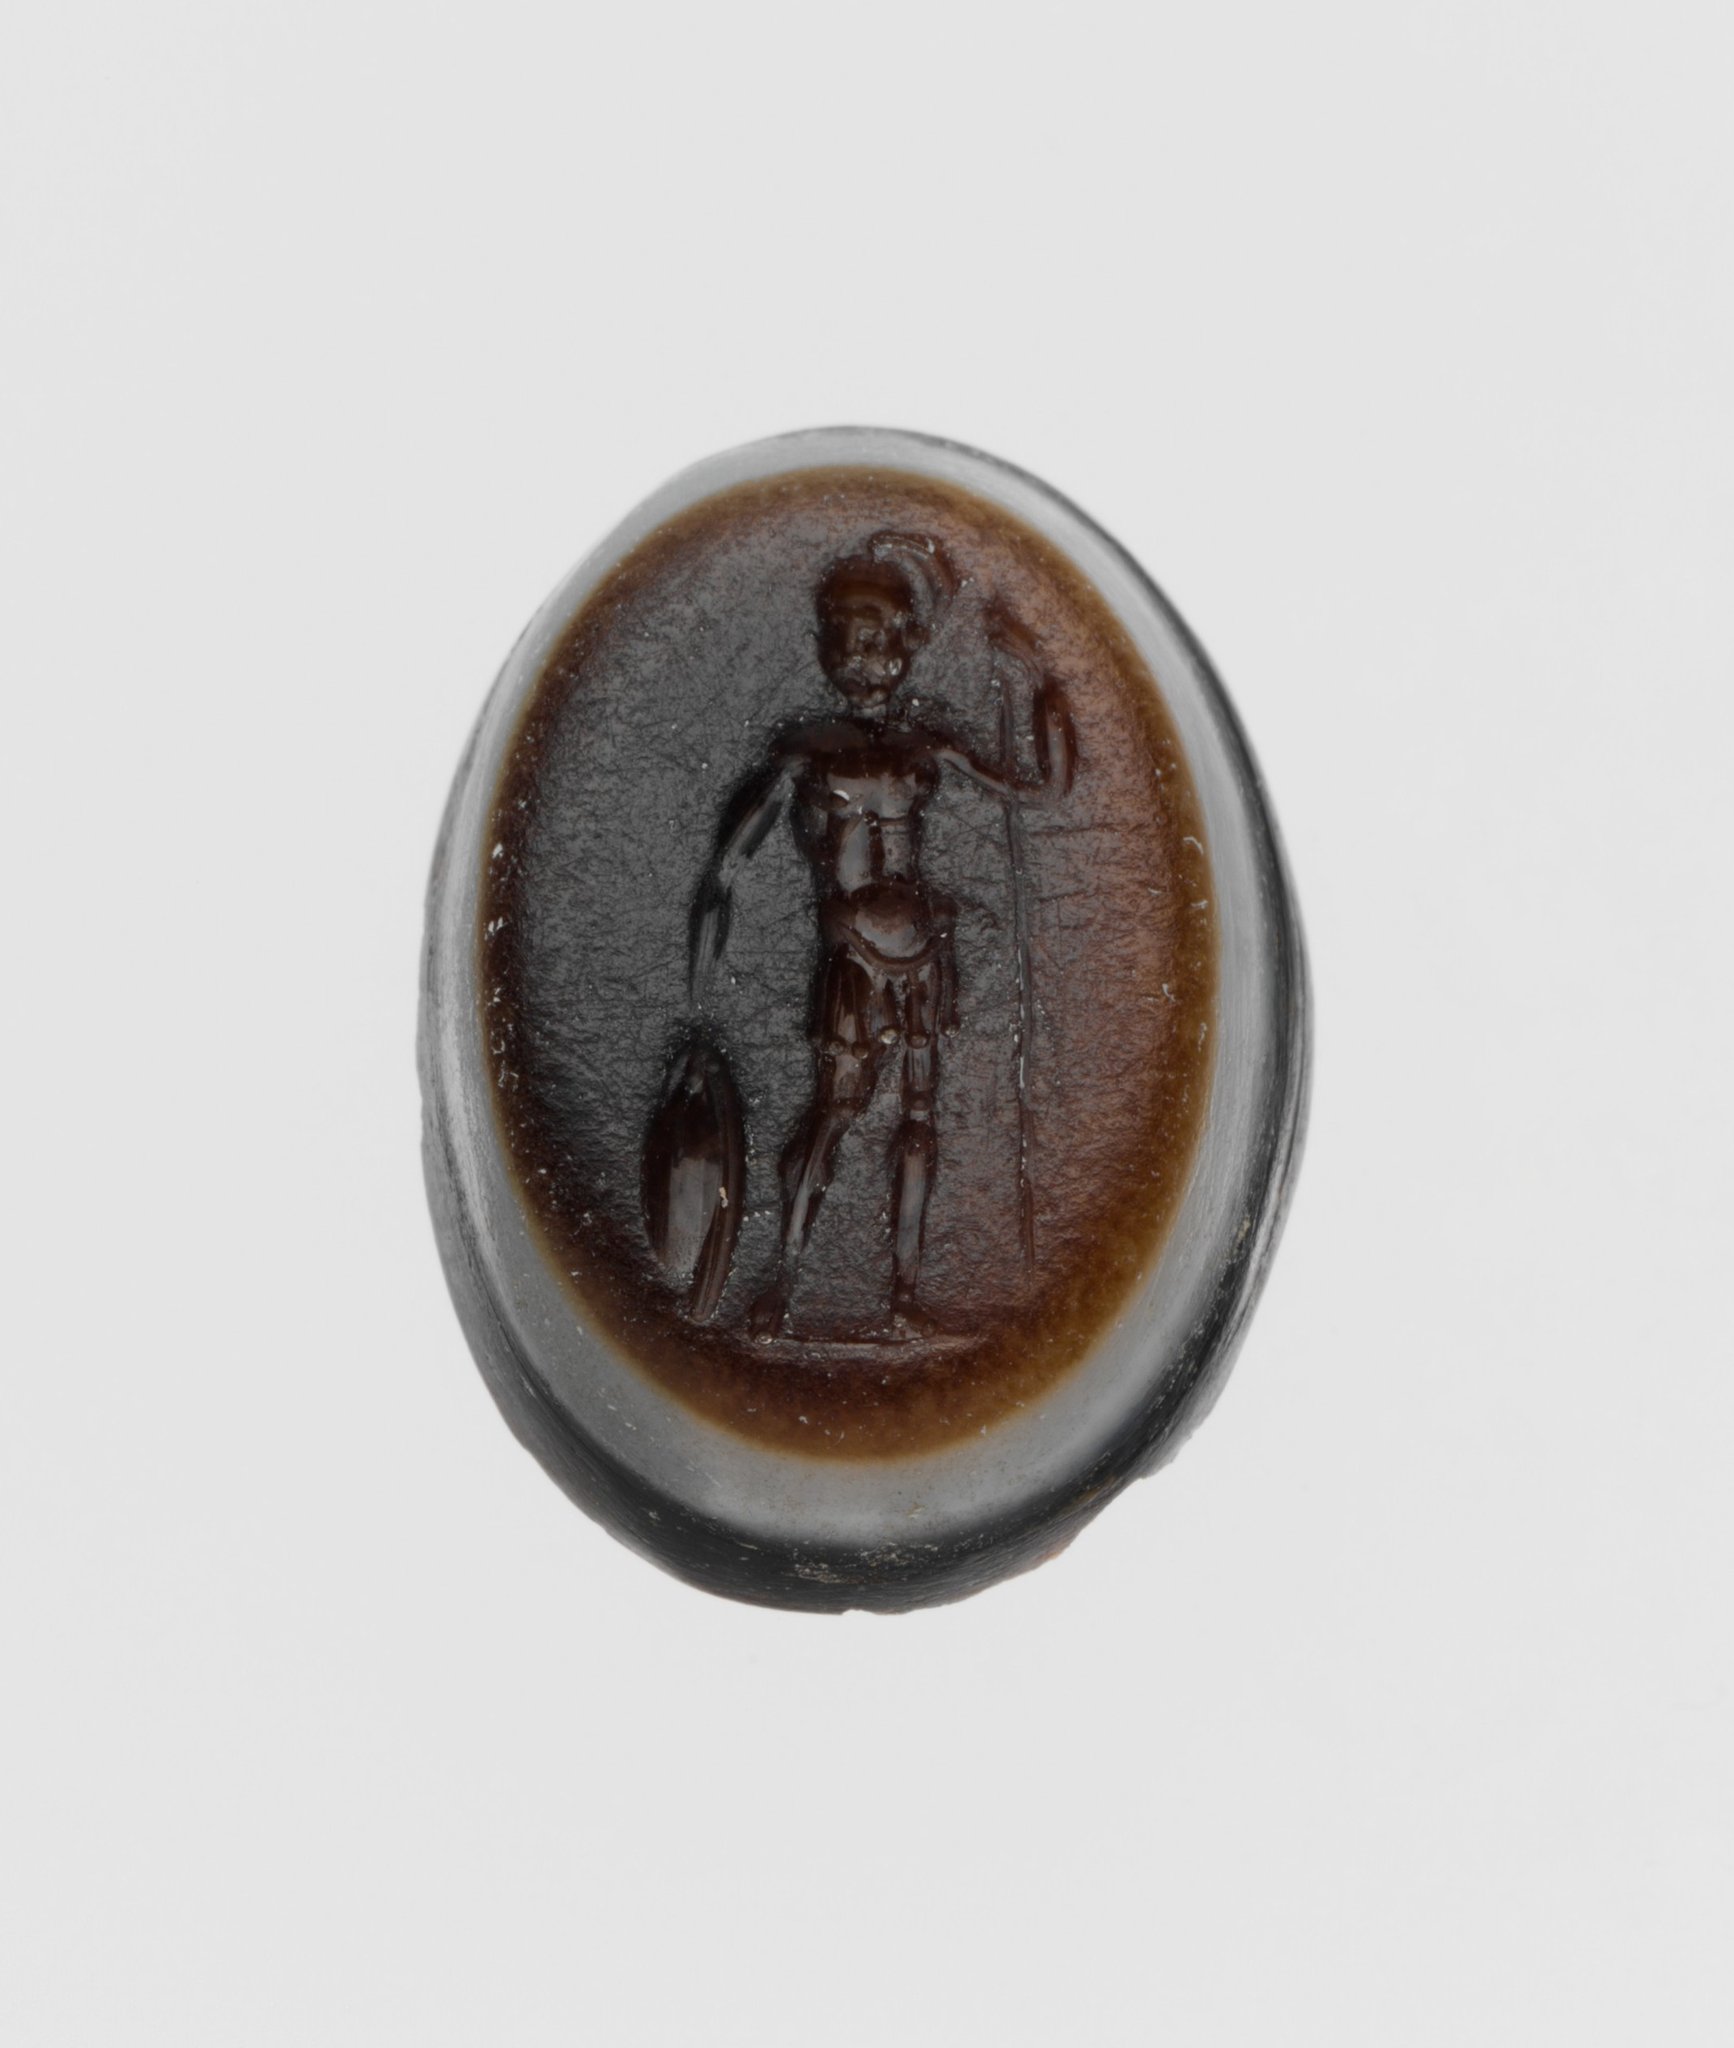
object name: intaglio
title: Sardonyx ring stone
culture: roman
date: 1-100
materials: gemstone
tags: shields,spears,ares